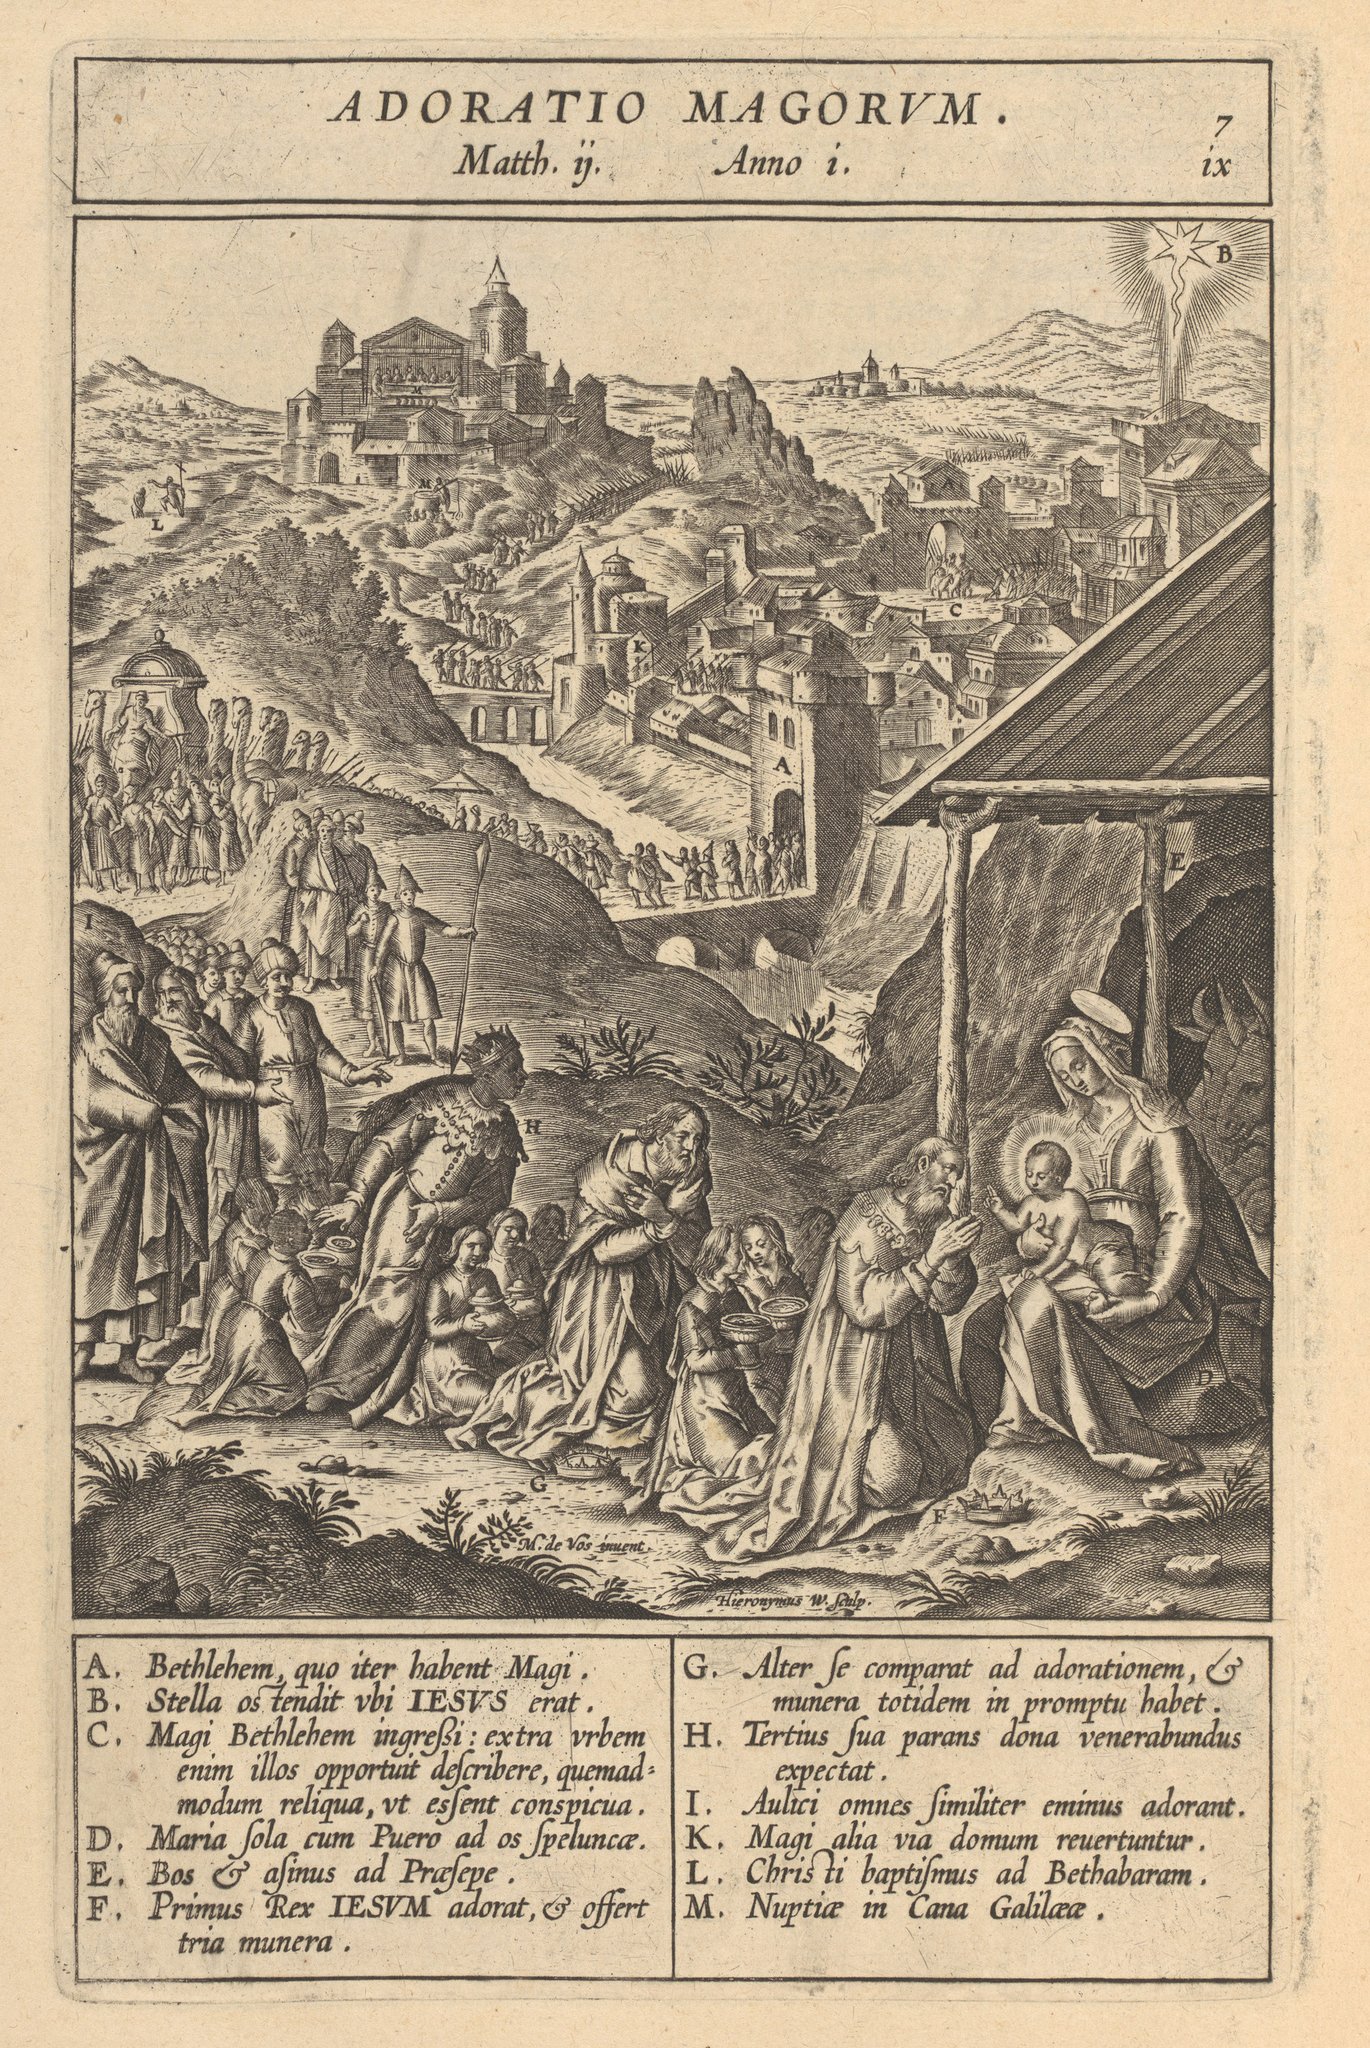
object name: book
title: Annotationes et Meditationes in Evangelia...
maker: hieronymus natalis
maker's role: author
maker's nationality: netherlandish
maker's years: 16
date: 1707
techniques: engraving